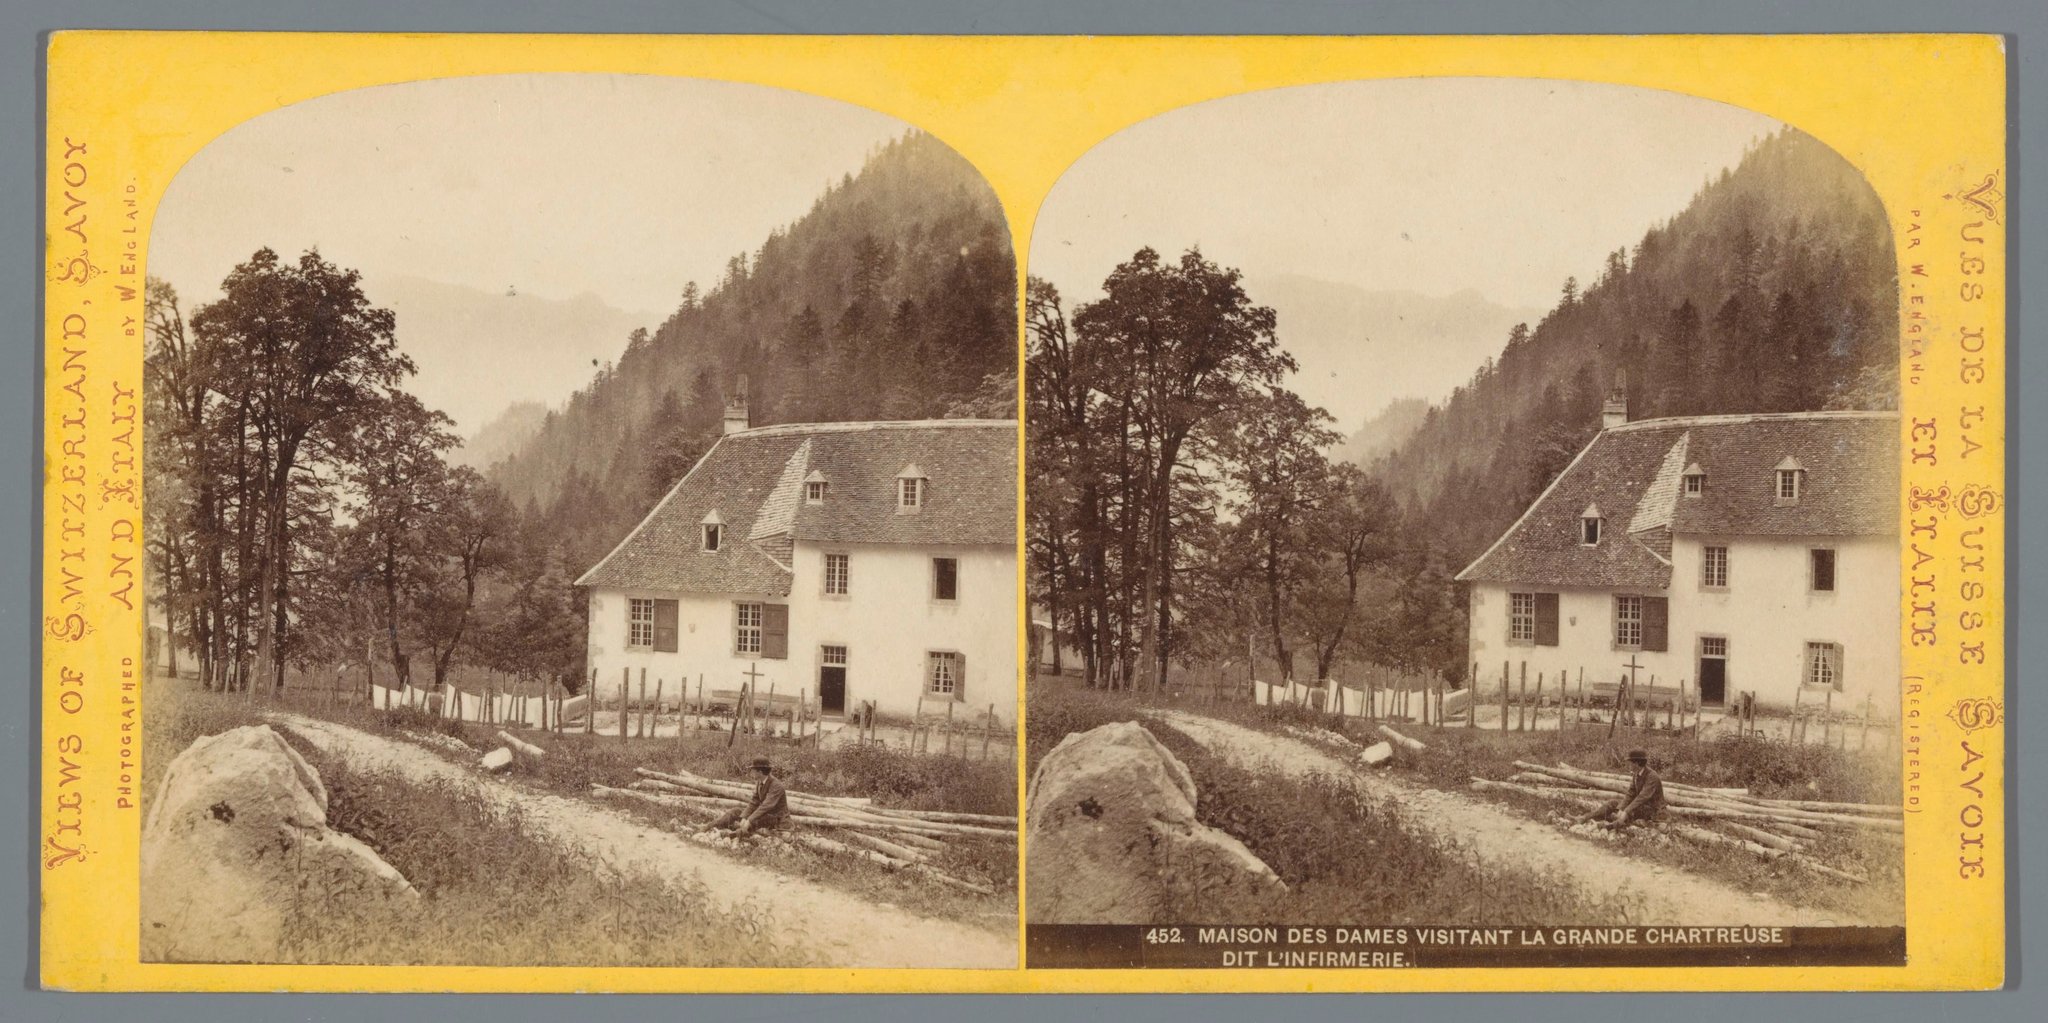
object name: stereograph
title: Gezicht op de ziekenzaal van het klooster La Grande Chartreuse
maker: william england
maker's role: fotograaf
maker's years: 1816-1896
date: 1850-1880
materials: cardboard, photographic support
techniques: albumen print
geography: grande chartreuse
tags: cloisters ~ monastery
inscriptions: inscription: ‘Vues de la Suisse Savoie et Italie’, number: ‘452.’